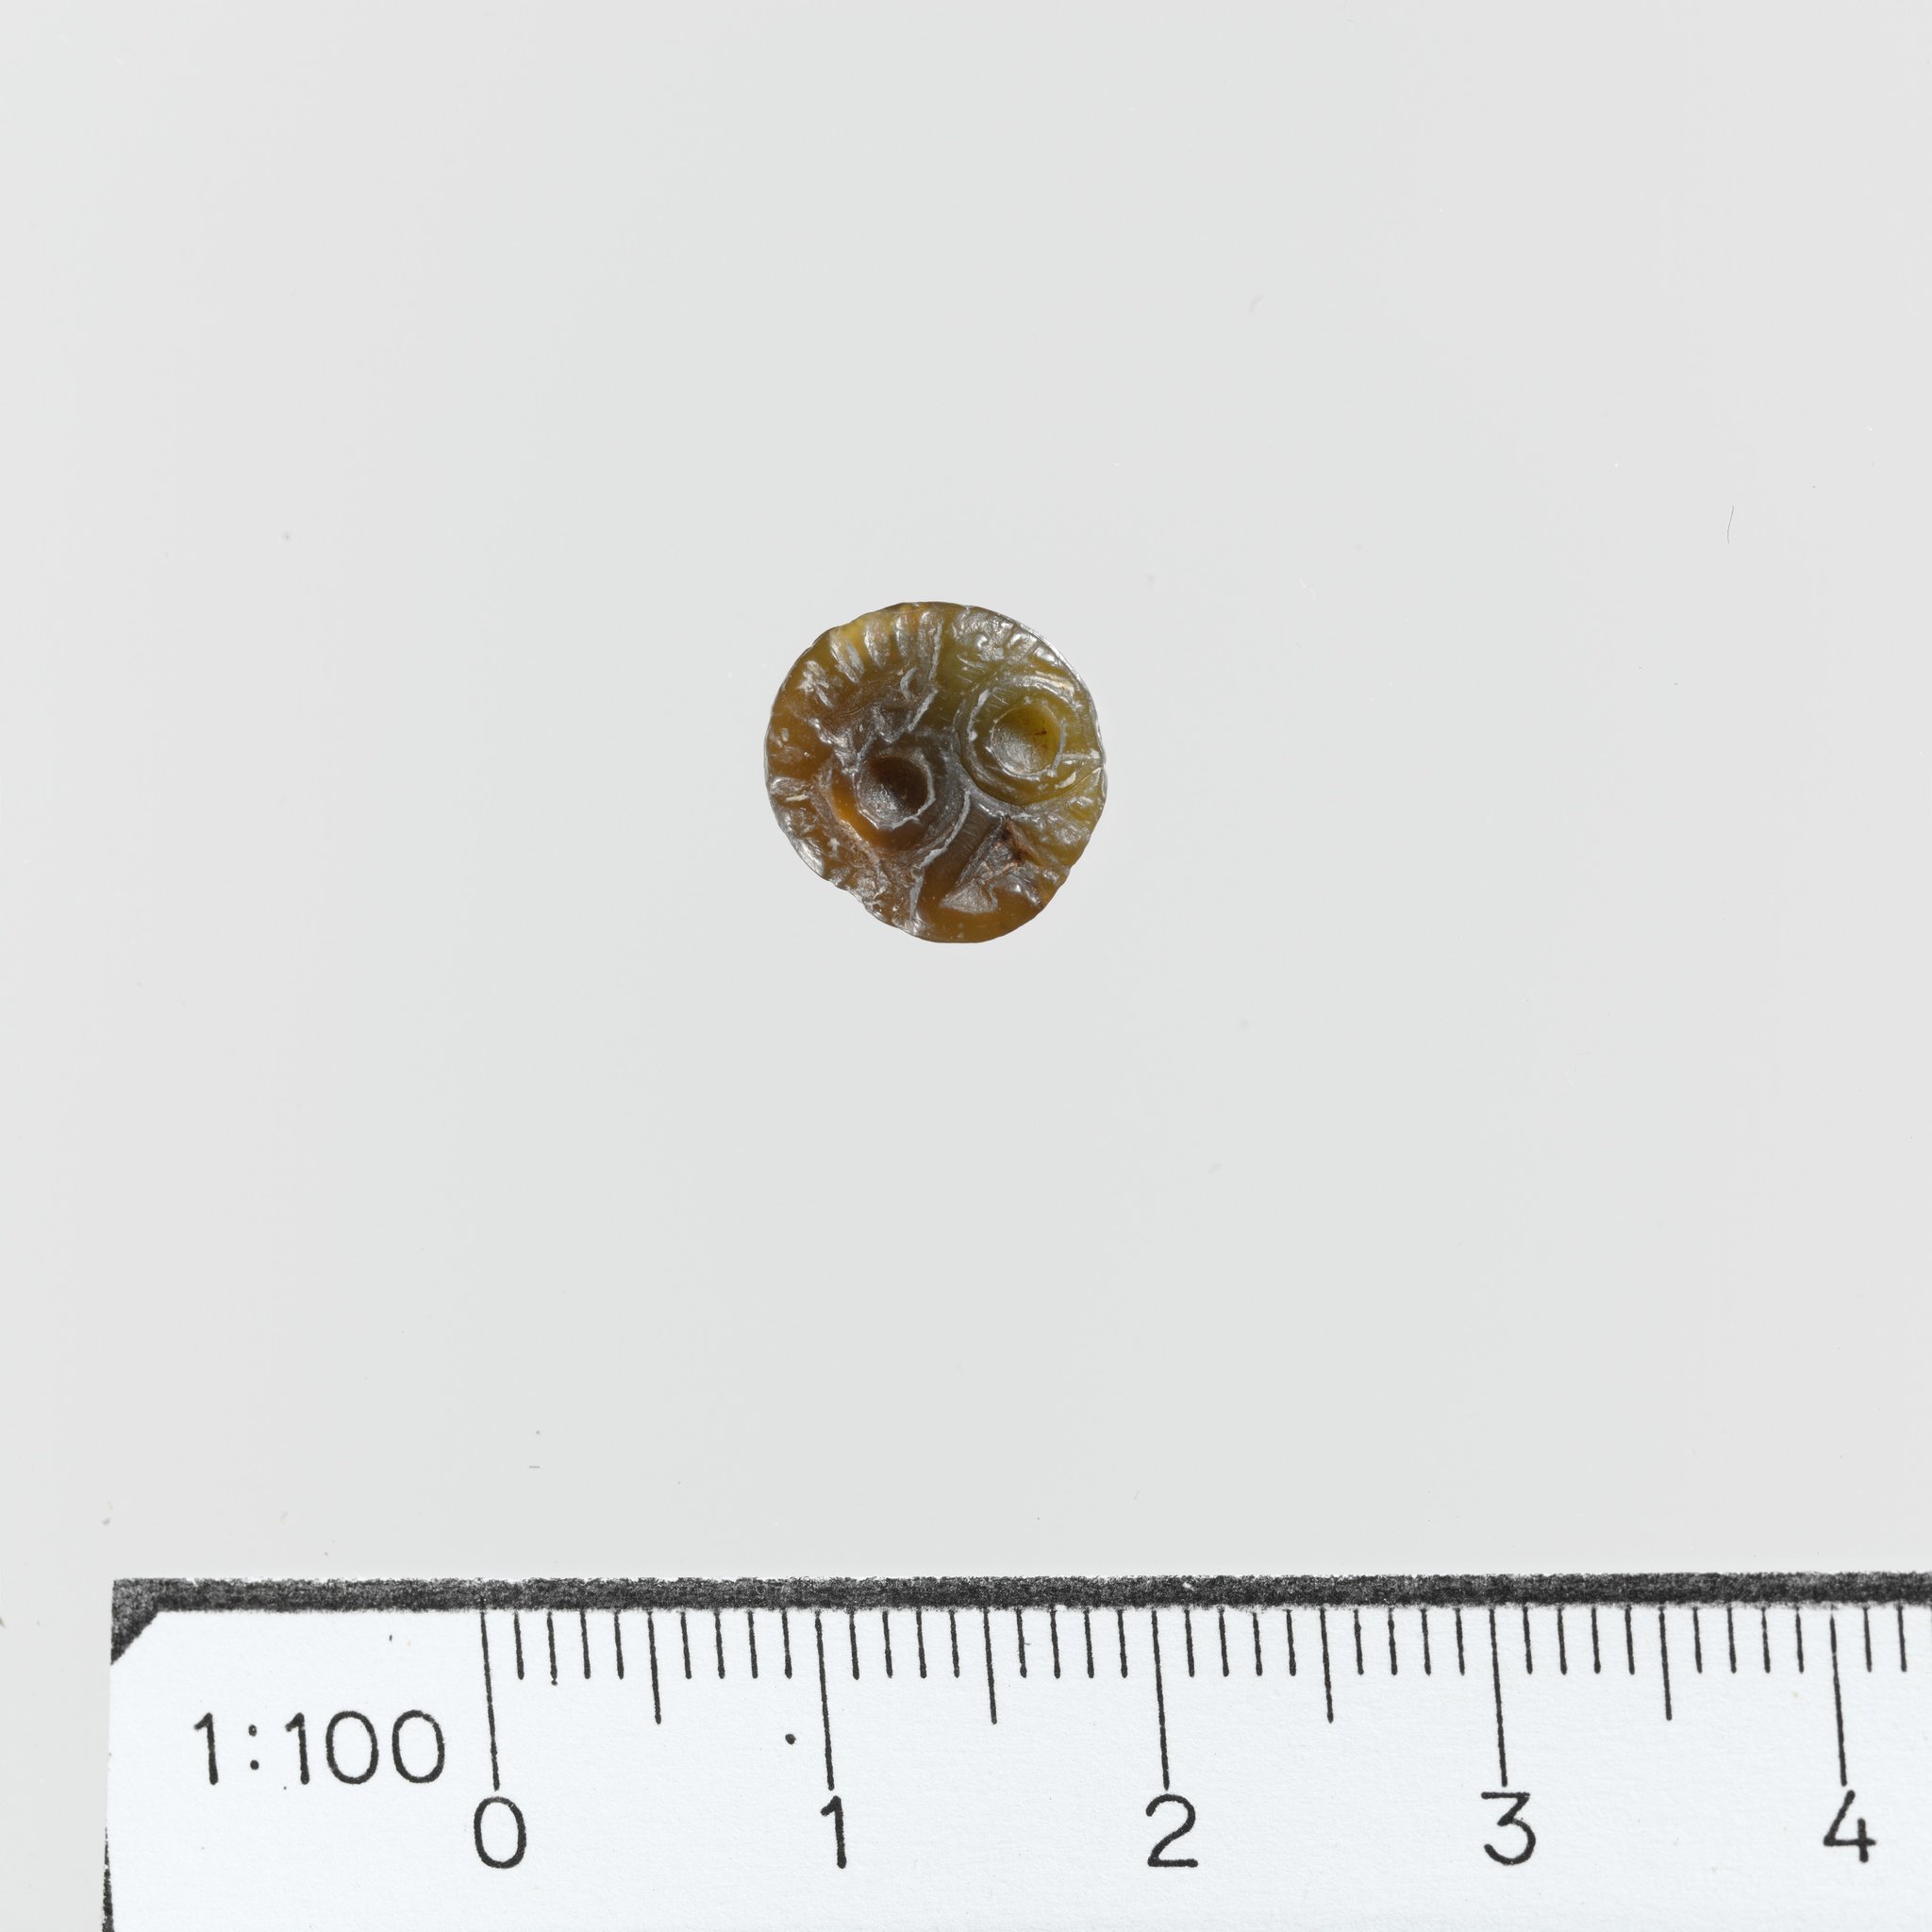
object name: seal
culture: minoan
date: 2600-2000 BCE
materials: stone